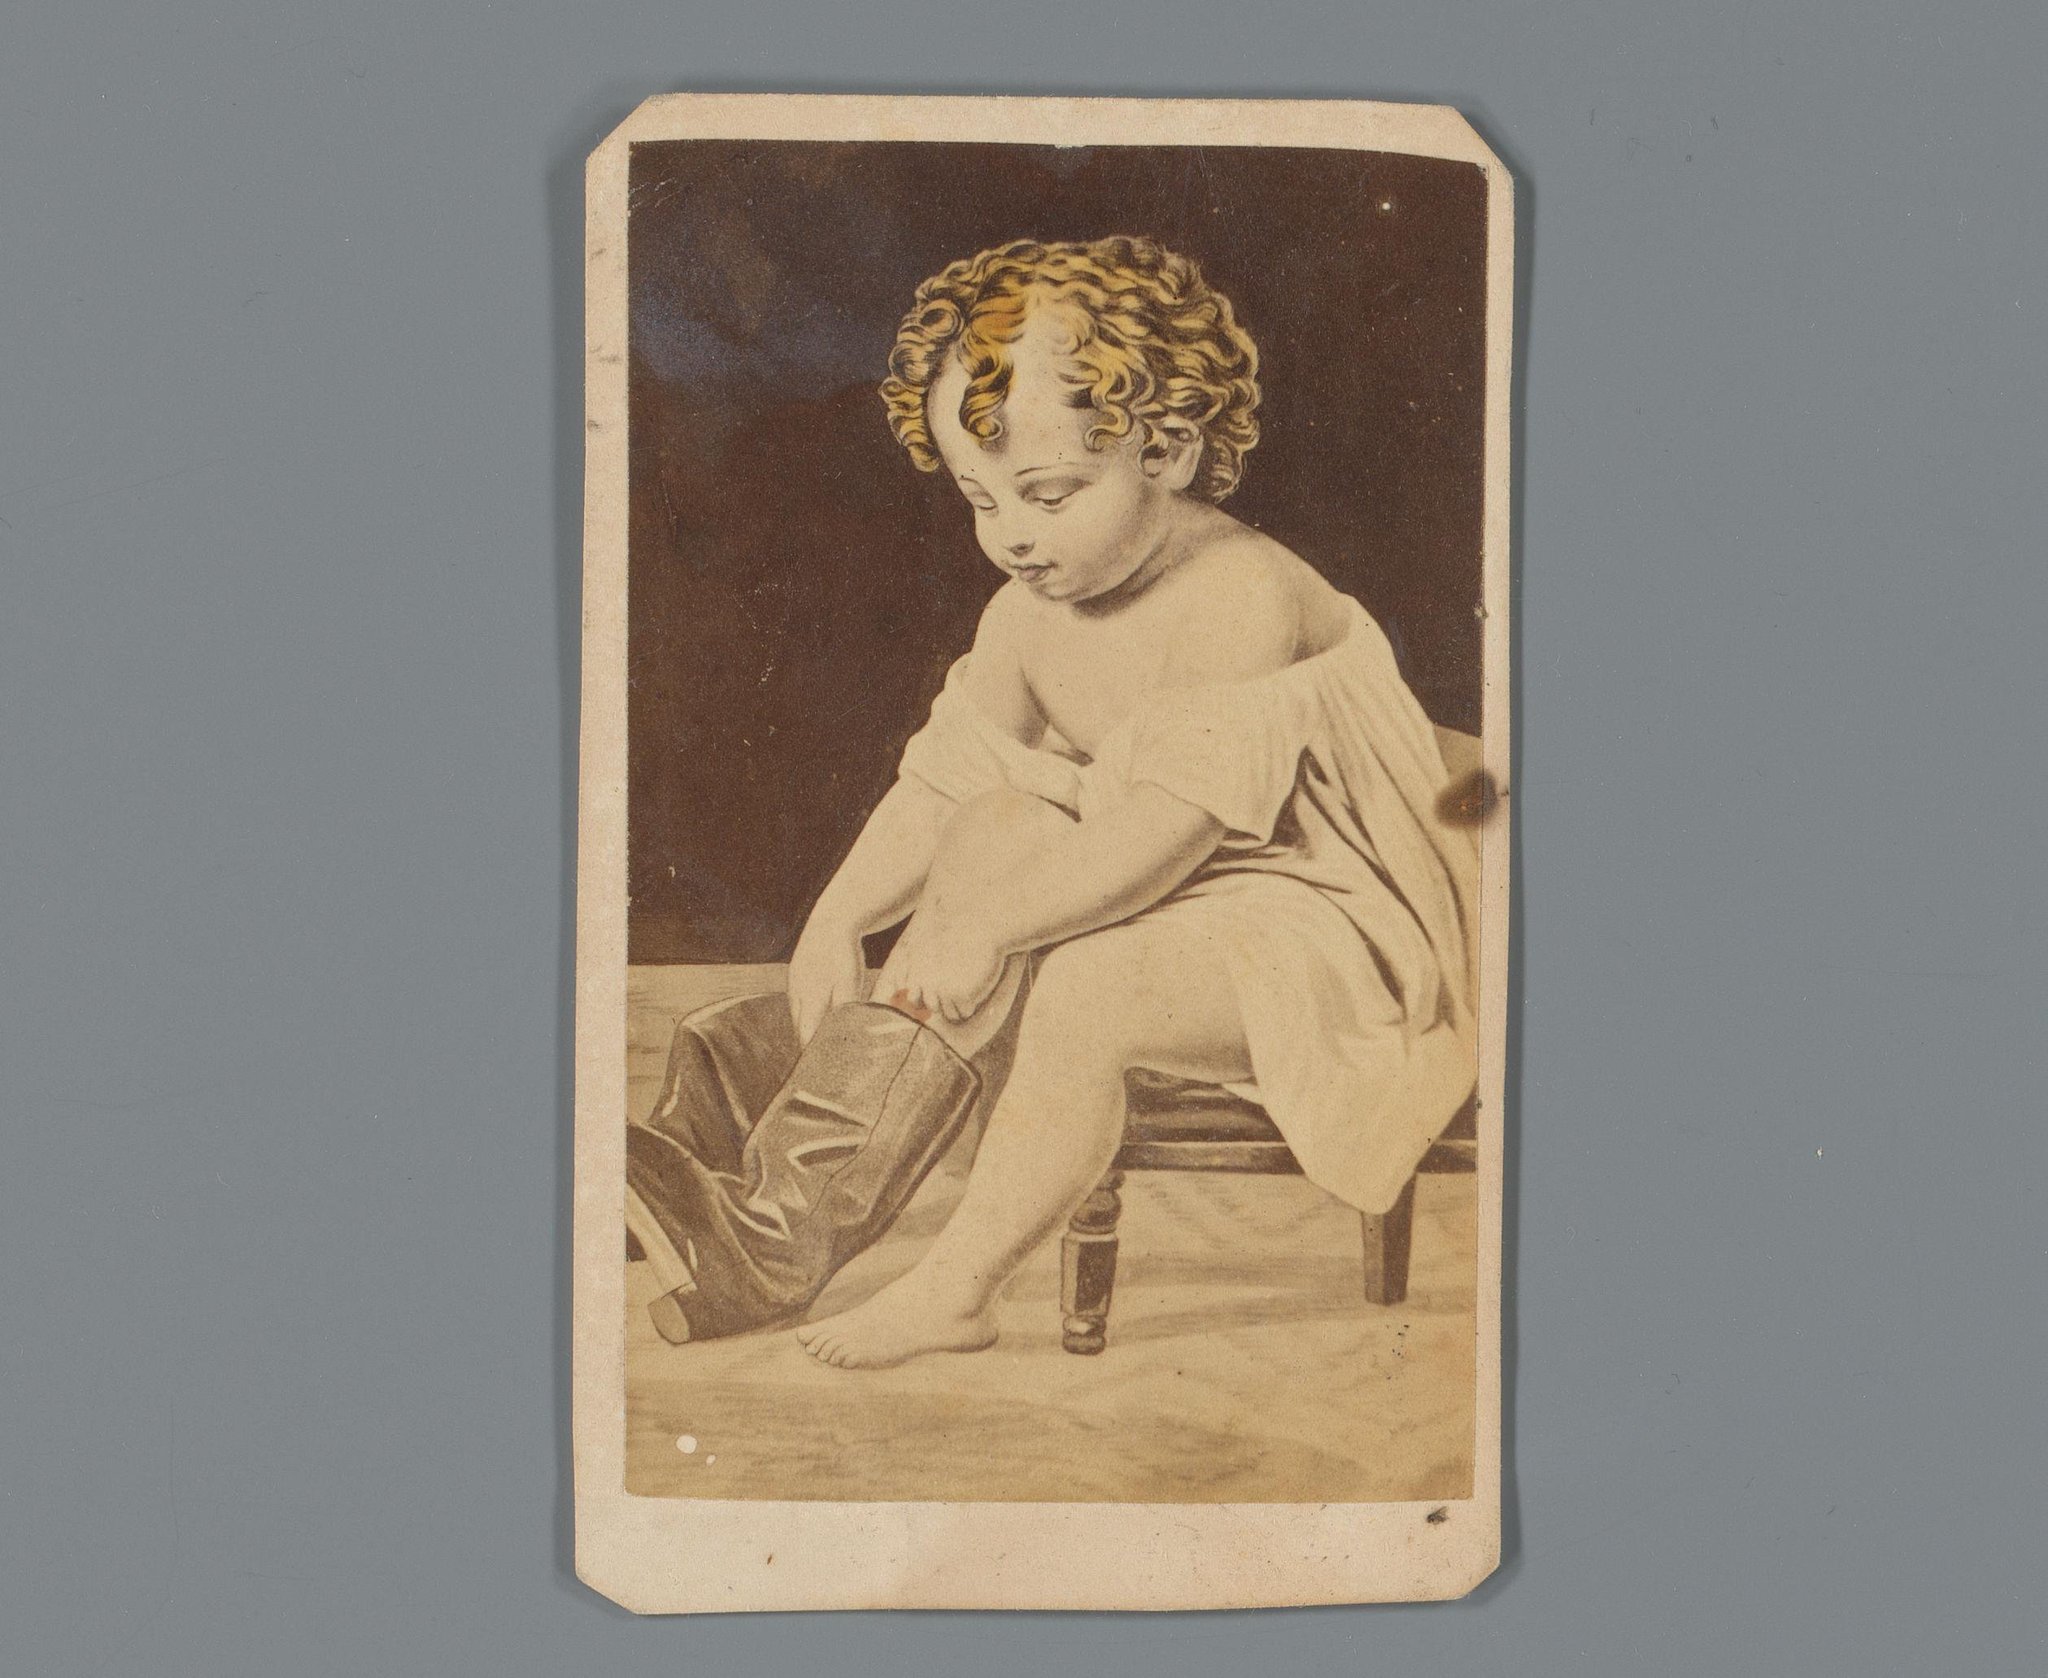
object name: reproduction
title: Fotoreproductie van een tekening van een kind dat een laars aantrekt als reclame voor kledingzaak Pierson & Hews in New Orleans, Louisiana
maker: Anonymous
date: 1850-1915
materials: cardboard, photographic support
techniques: albumen print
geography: new orleans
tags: advertising, child, boots, textile industry and clothing industry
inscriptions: inscription: ‘PIERSON & HEWS, Successors to PITKIN, PIERSON & CO/ DEALERS IN/ FINE CLOTHING/ AND/ FURNISHING GOODS/ No.s 13 and 15 Camp Street,/ Wm. H. Pierson,/ E.L. Hews/ New Orleans’